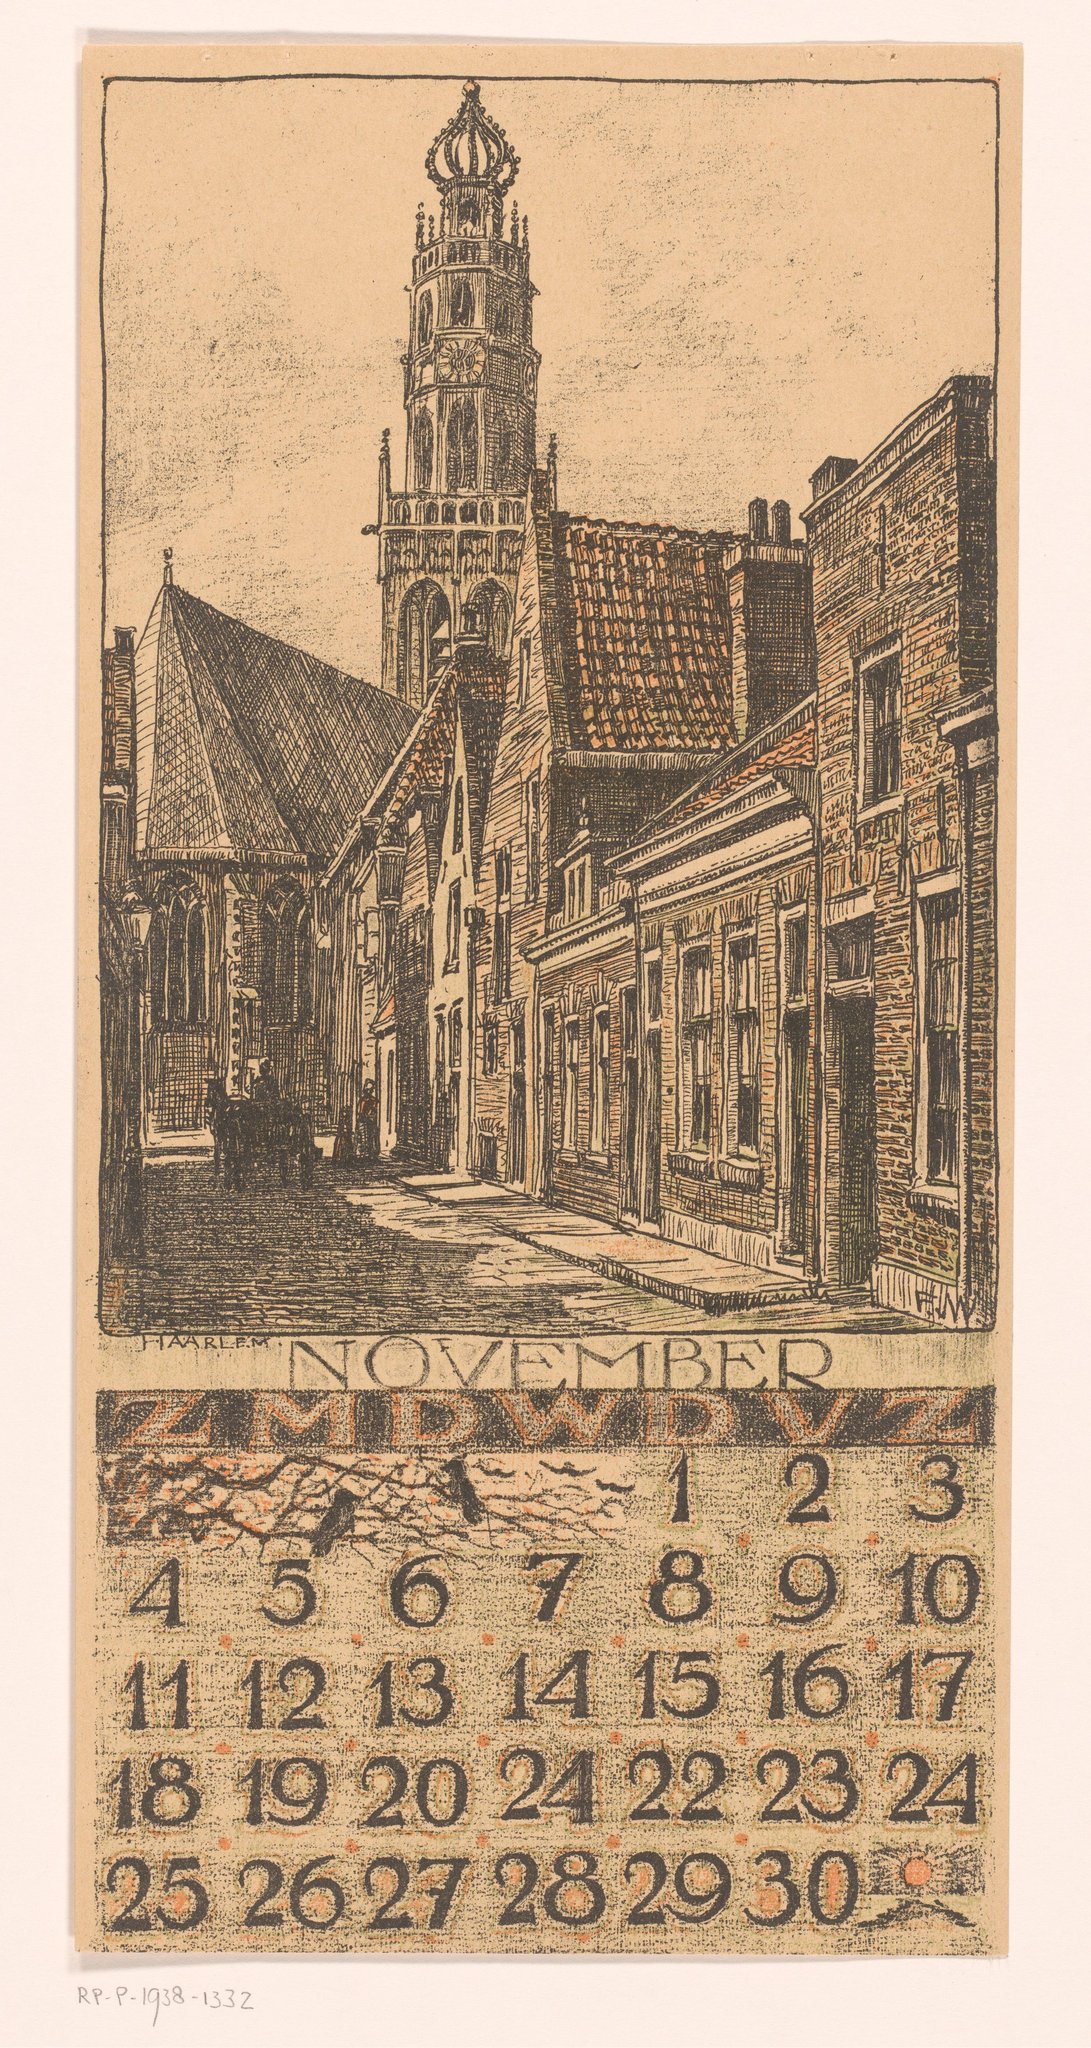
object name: print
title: Kalenderblad november met stadsgezicht in Haarlem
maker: ferdinand van wolde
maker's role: print maker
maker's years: 1891-1945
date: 1923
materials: paper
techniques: lithograph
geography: netherlands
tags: church (exterior), november ~ other concepts, street (+ city(-scape) with figures, staffage)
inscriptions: collector's mark: Lugt 2760, collector's mark: Lugt 2228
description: Straatgezicht met op de achtergrond de Grote of Sint-Bavokerk.